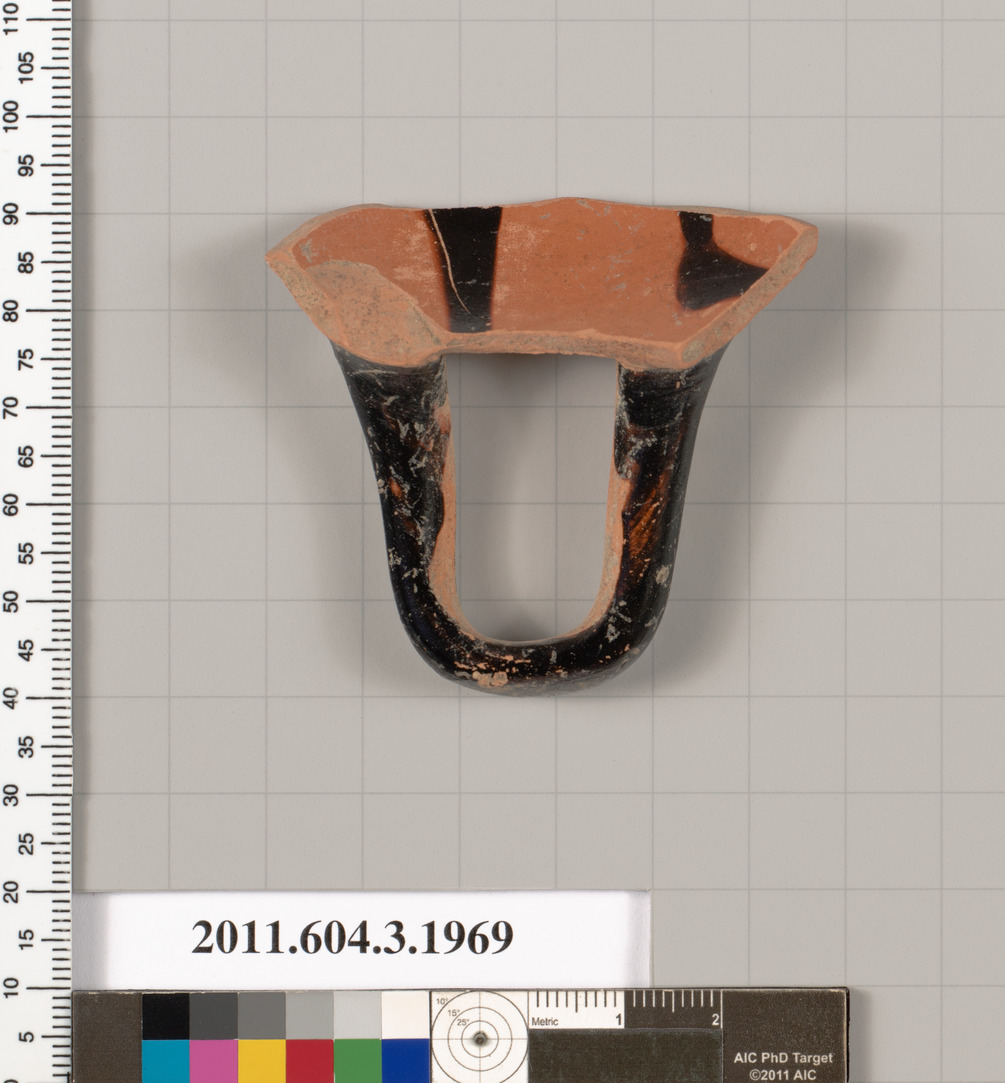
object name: kylix fragment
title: Terracotta fragment of a kylix (drinking cup)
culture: greek, attic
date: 550-526 BCE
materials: terracotta